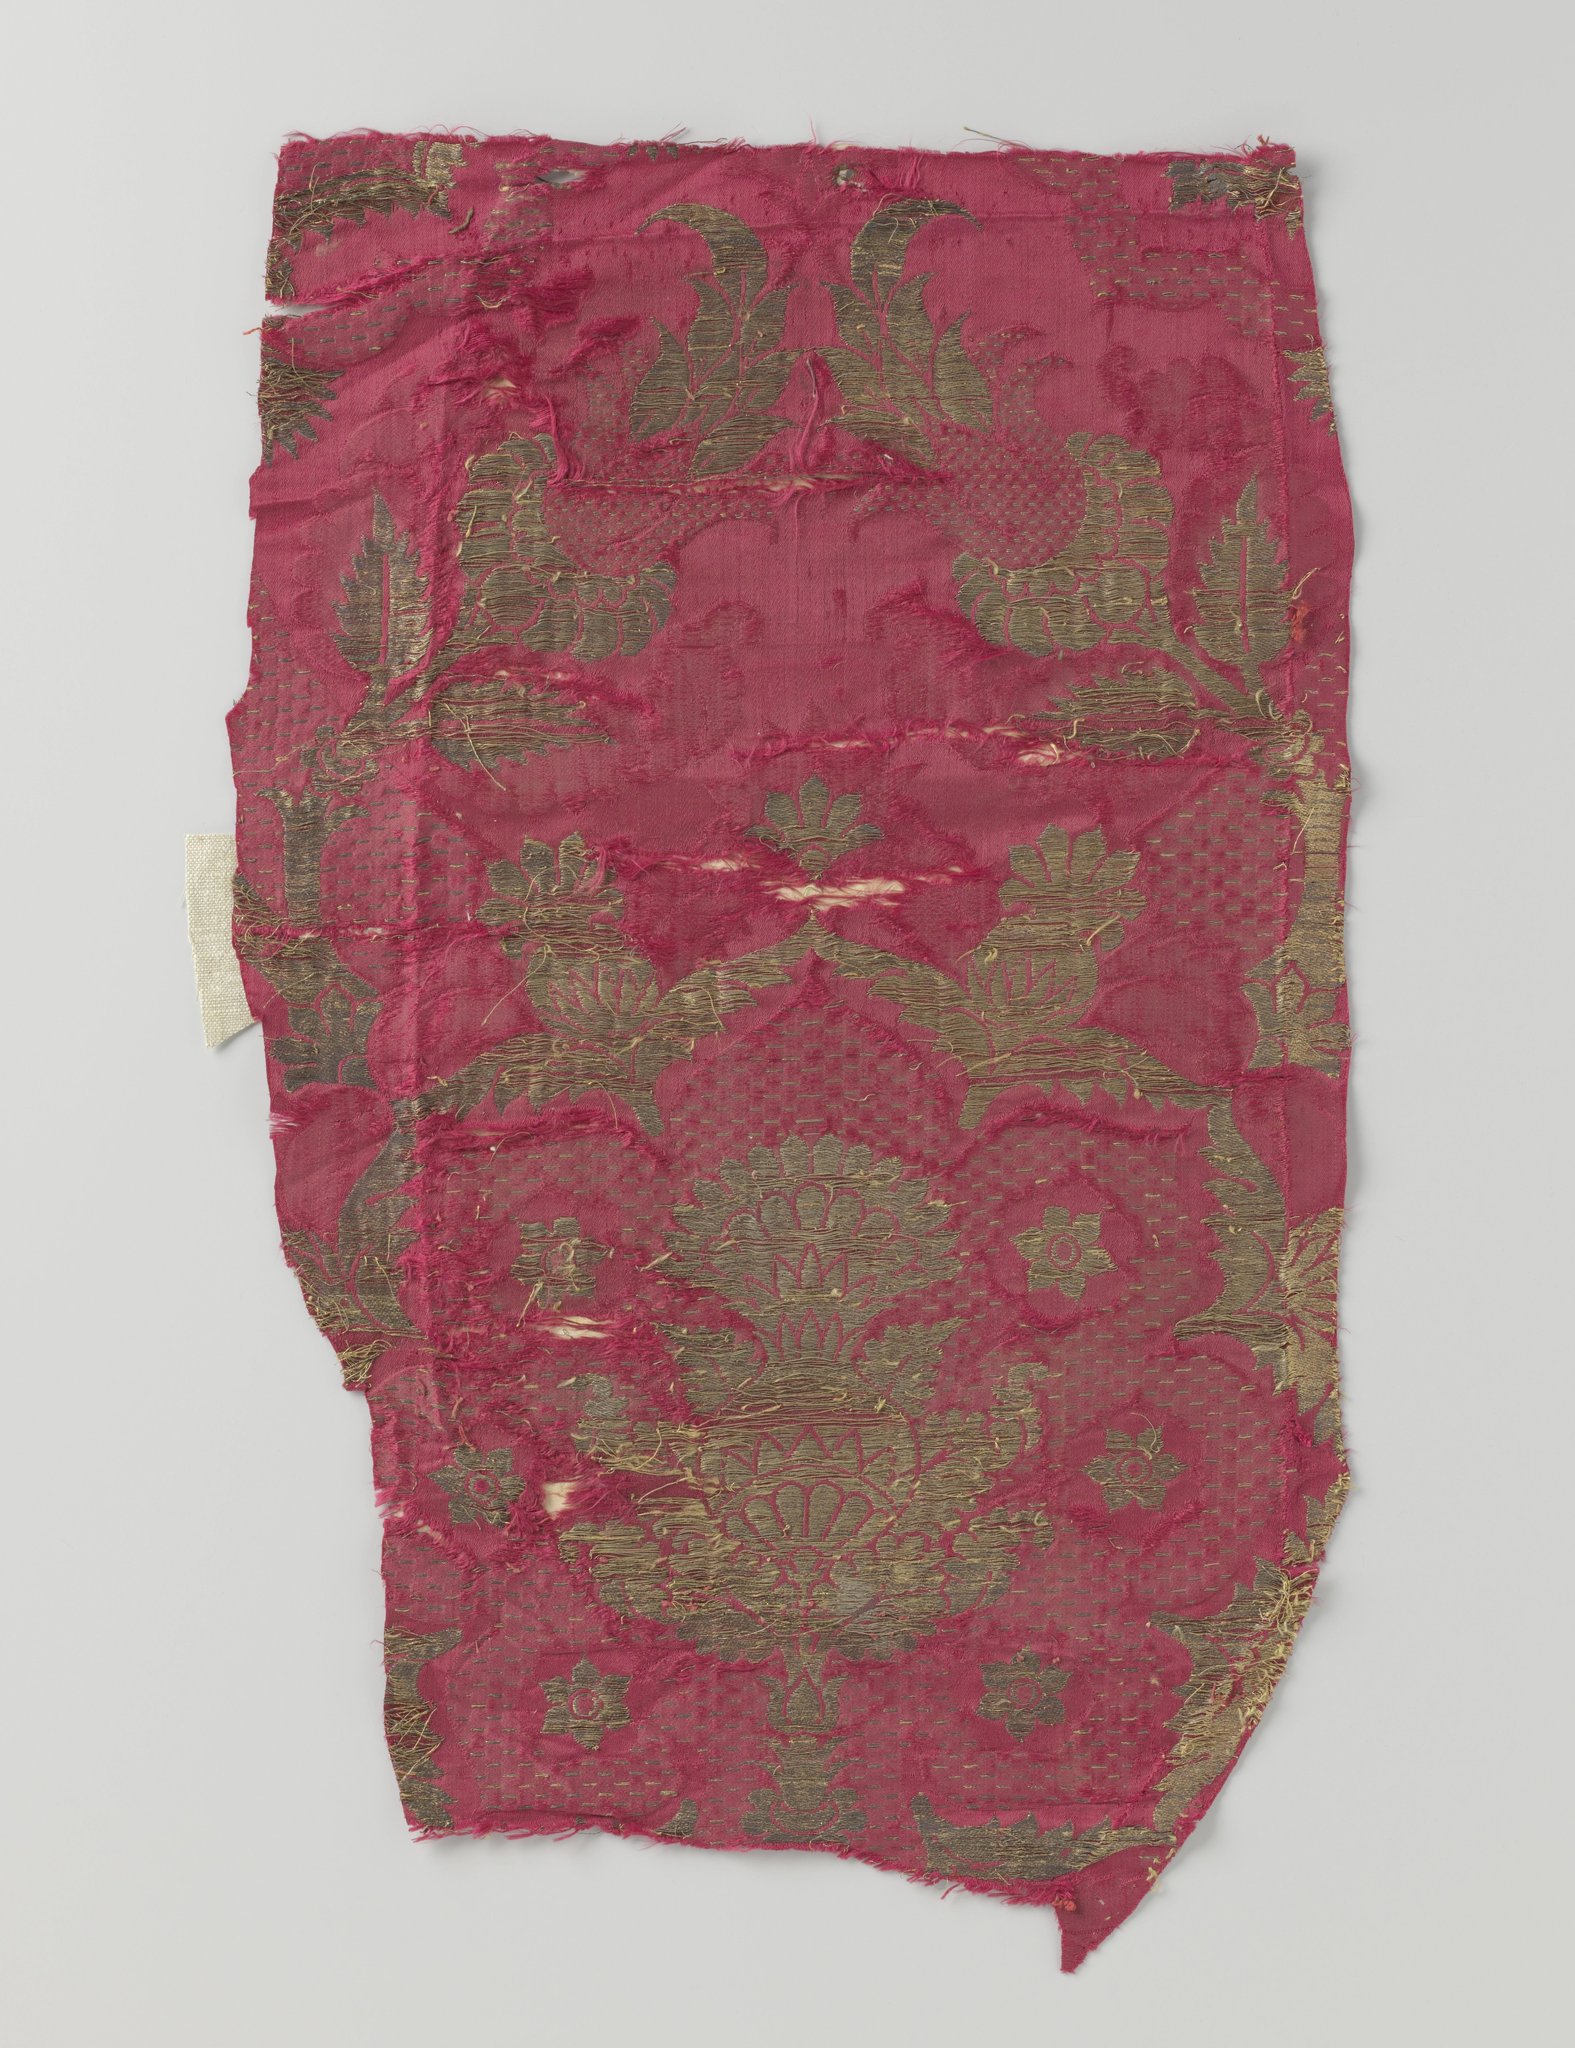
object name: damastbrokaat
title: Fragment rood damastbrokaat met granaatappelmotieven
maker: Anonymous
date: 1450-1499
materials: gold thread, silk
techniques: brocade, damask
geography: italy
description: Fragment van rode zijden damastbrokaat met granaatappelmotieven.